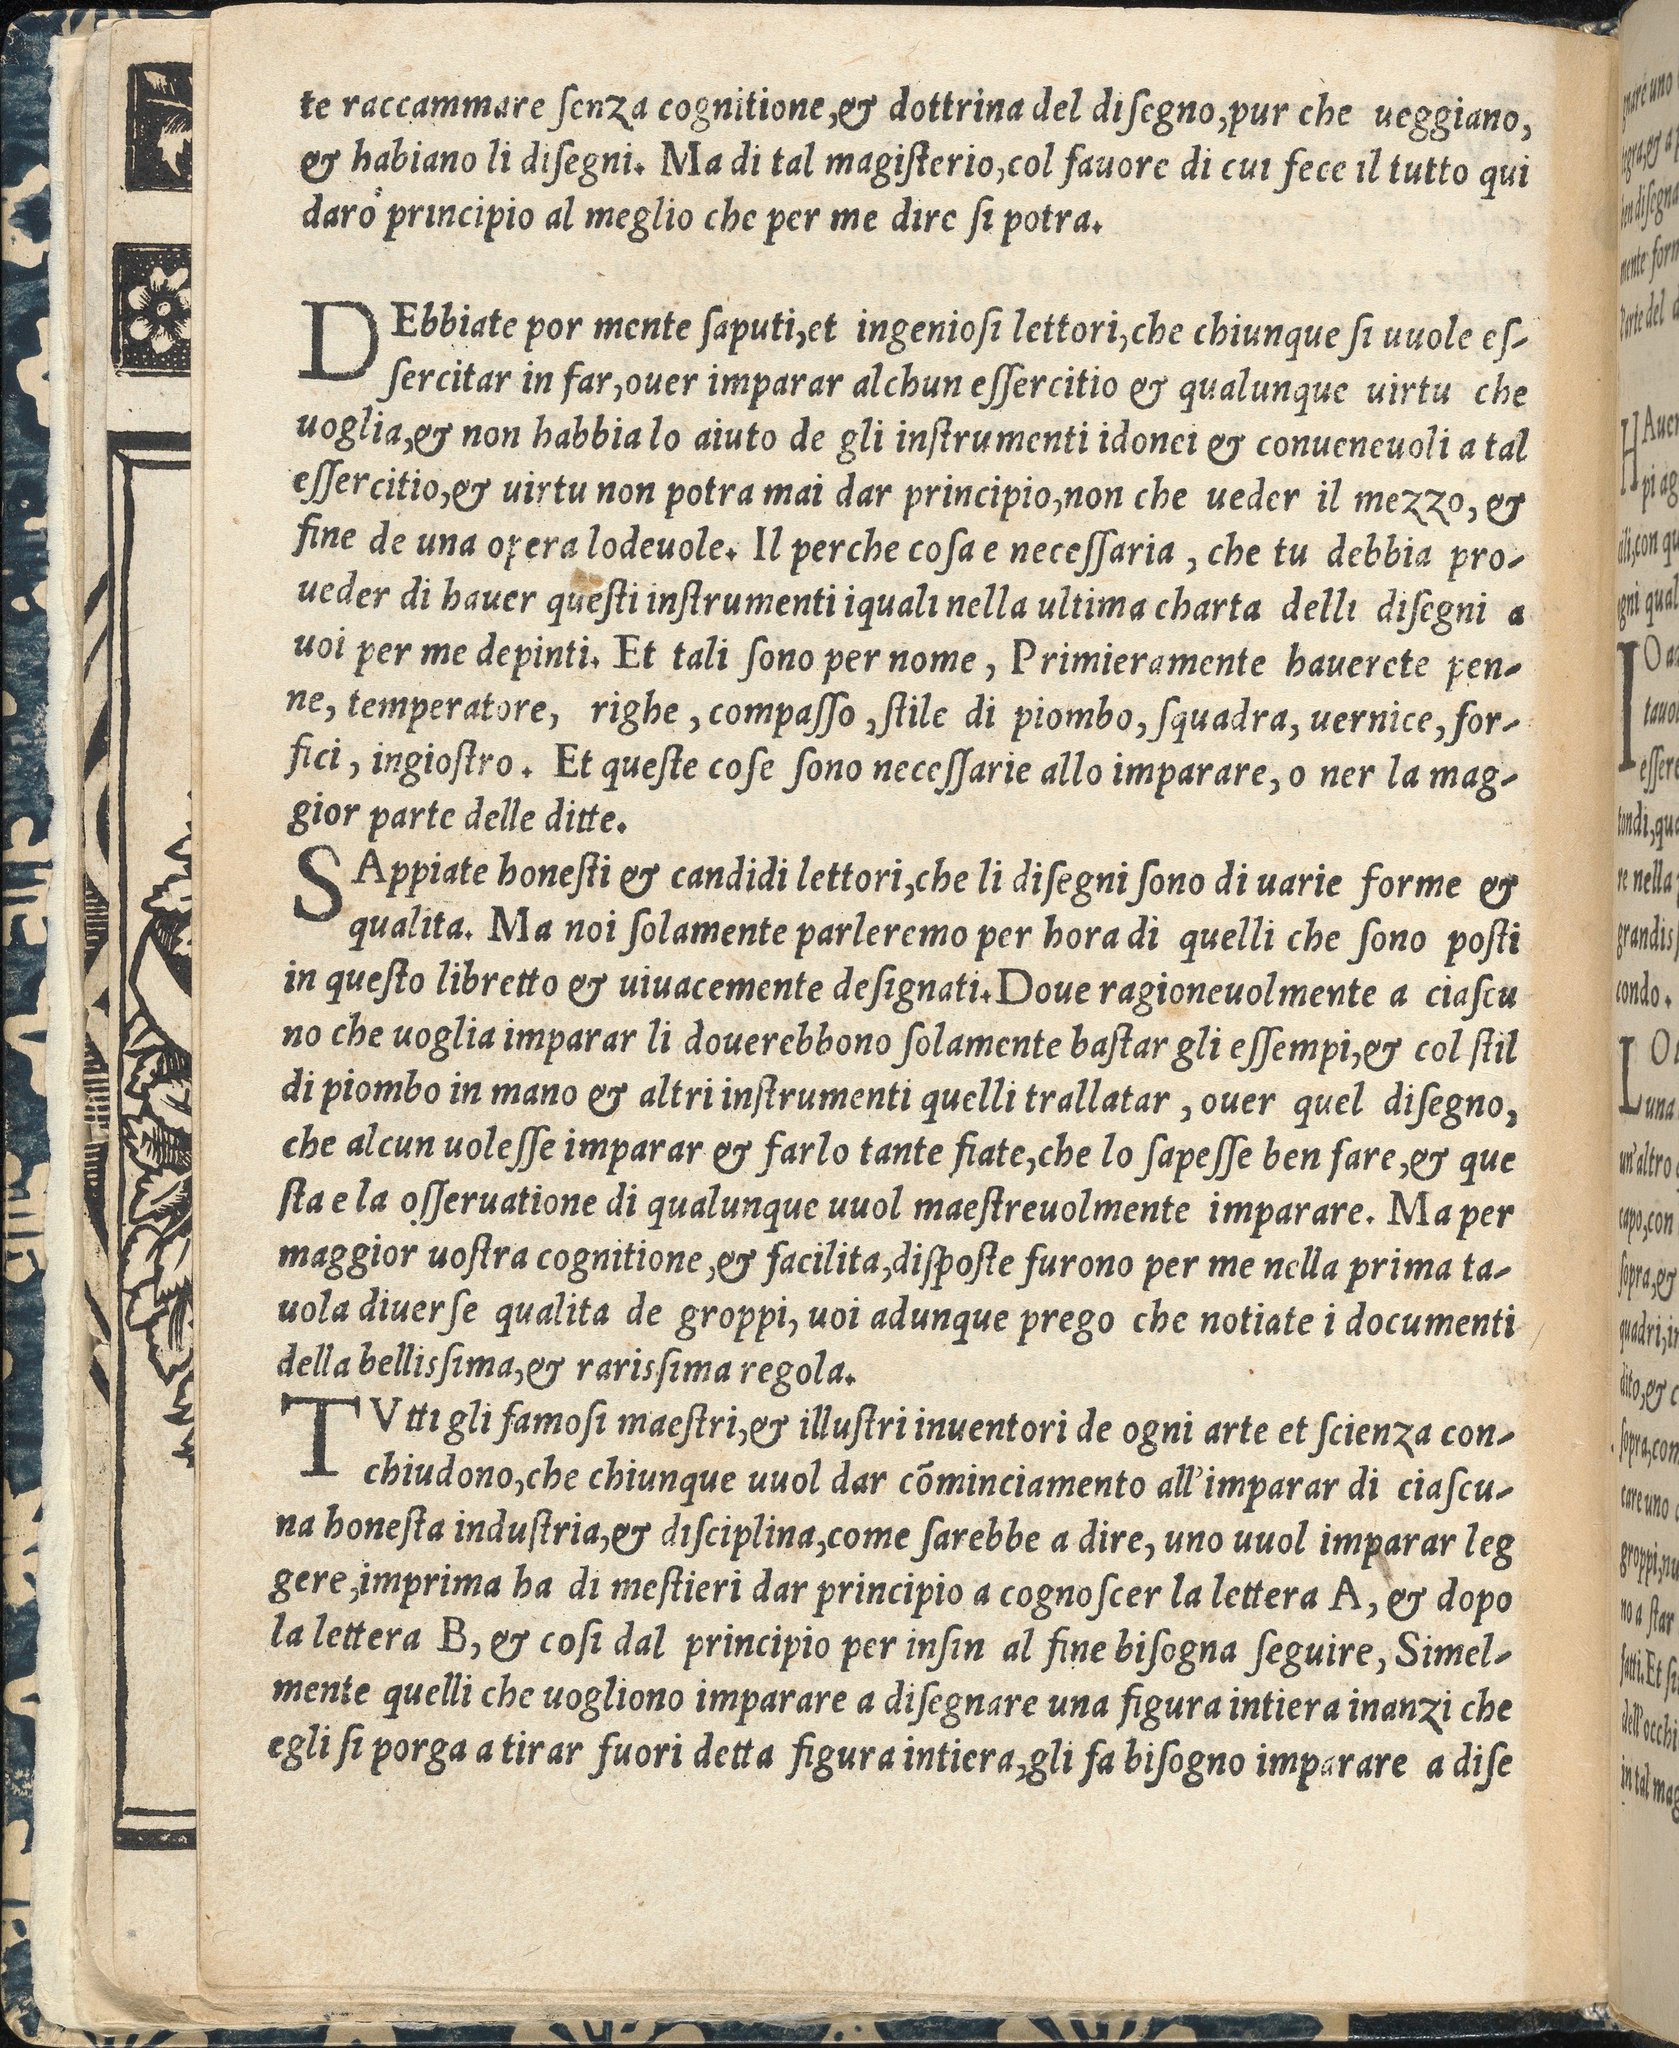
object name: book print ornament architecture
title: Essempio di recammi, page 26 (verso)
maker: giovanni antonio tagliente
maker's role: author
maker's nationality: italian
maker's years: 1465-1528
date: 1530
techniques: woodcut